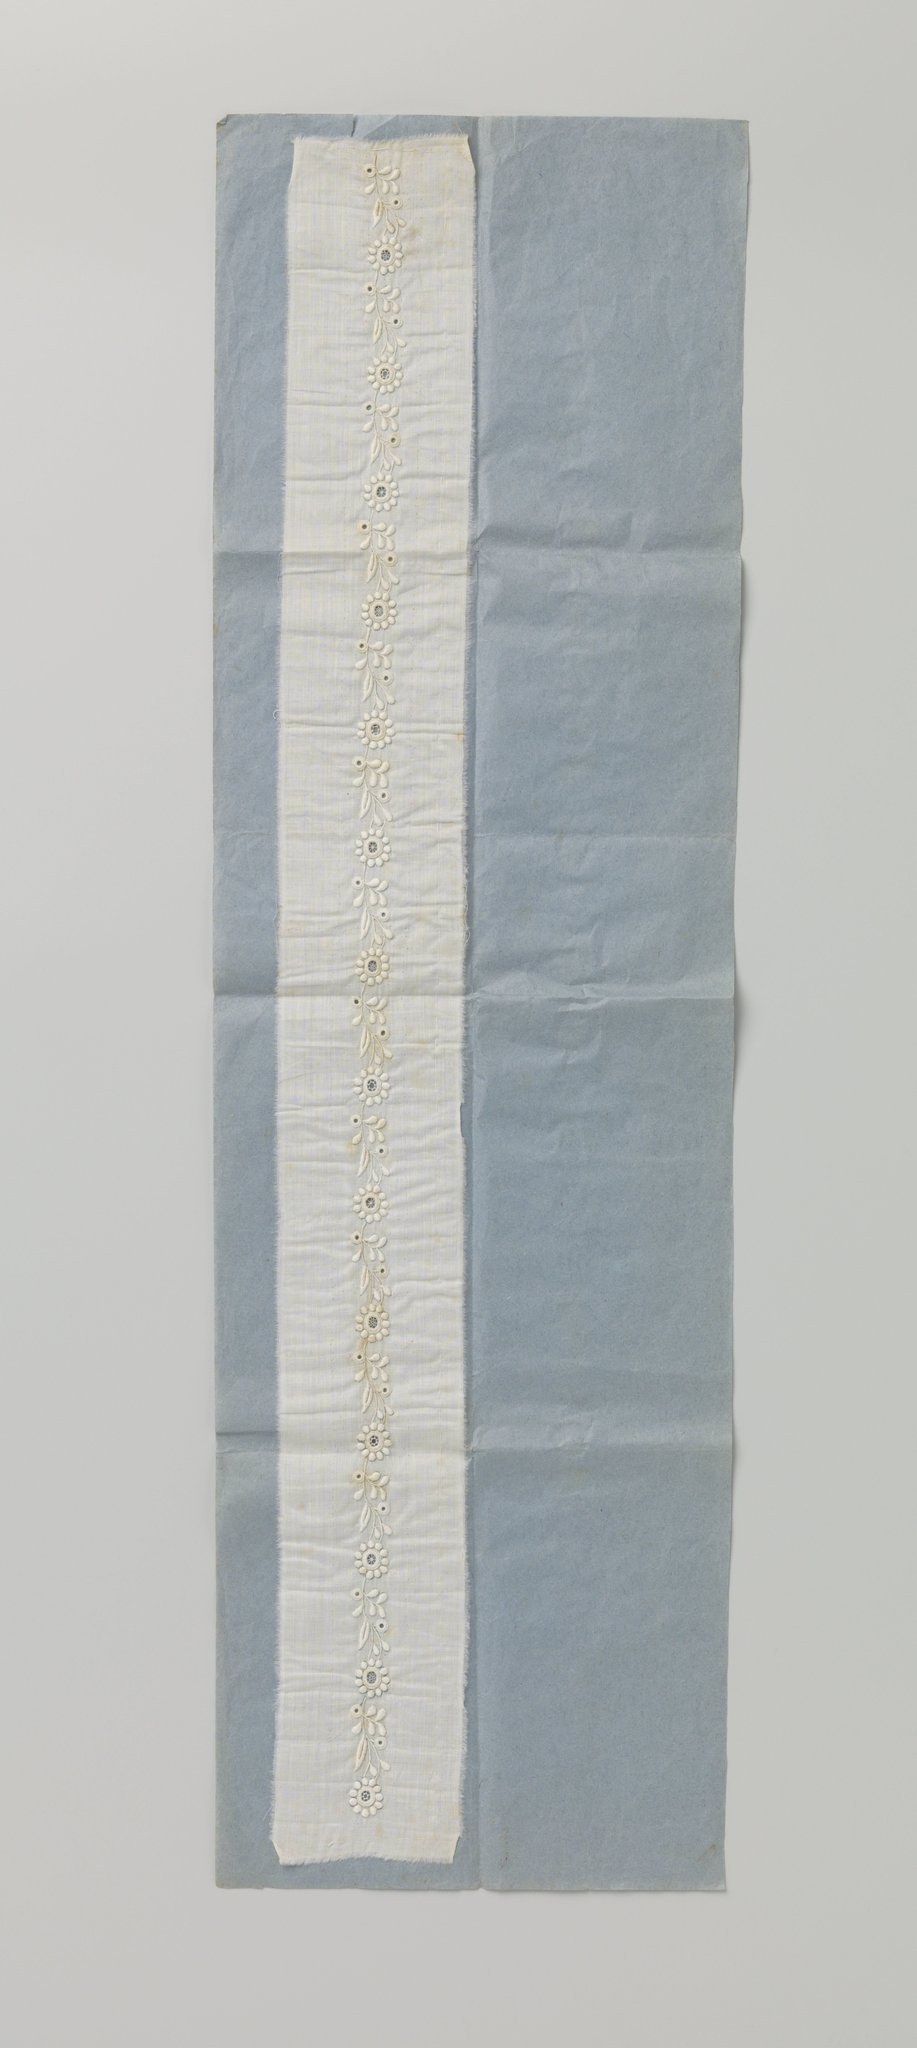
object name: werkstuk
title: Werkstuk voor Diploma fraaie handwerken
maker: geesje smid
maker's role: artisan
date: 1890-1900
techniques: embroidered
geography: netherlands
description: Strook batist met een lange rij bloemtakjes in plumetis borduurwerk in wit.